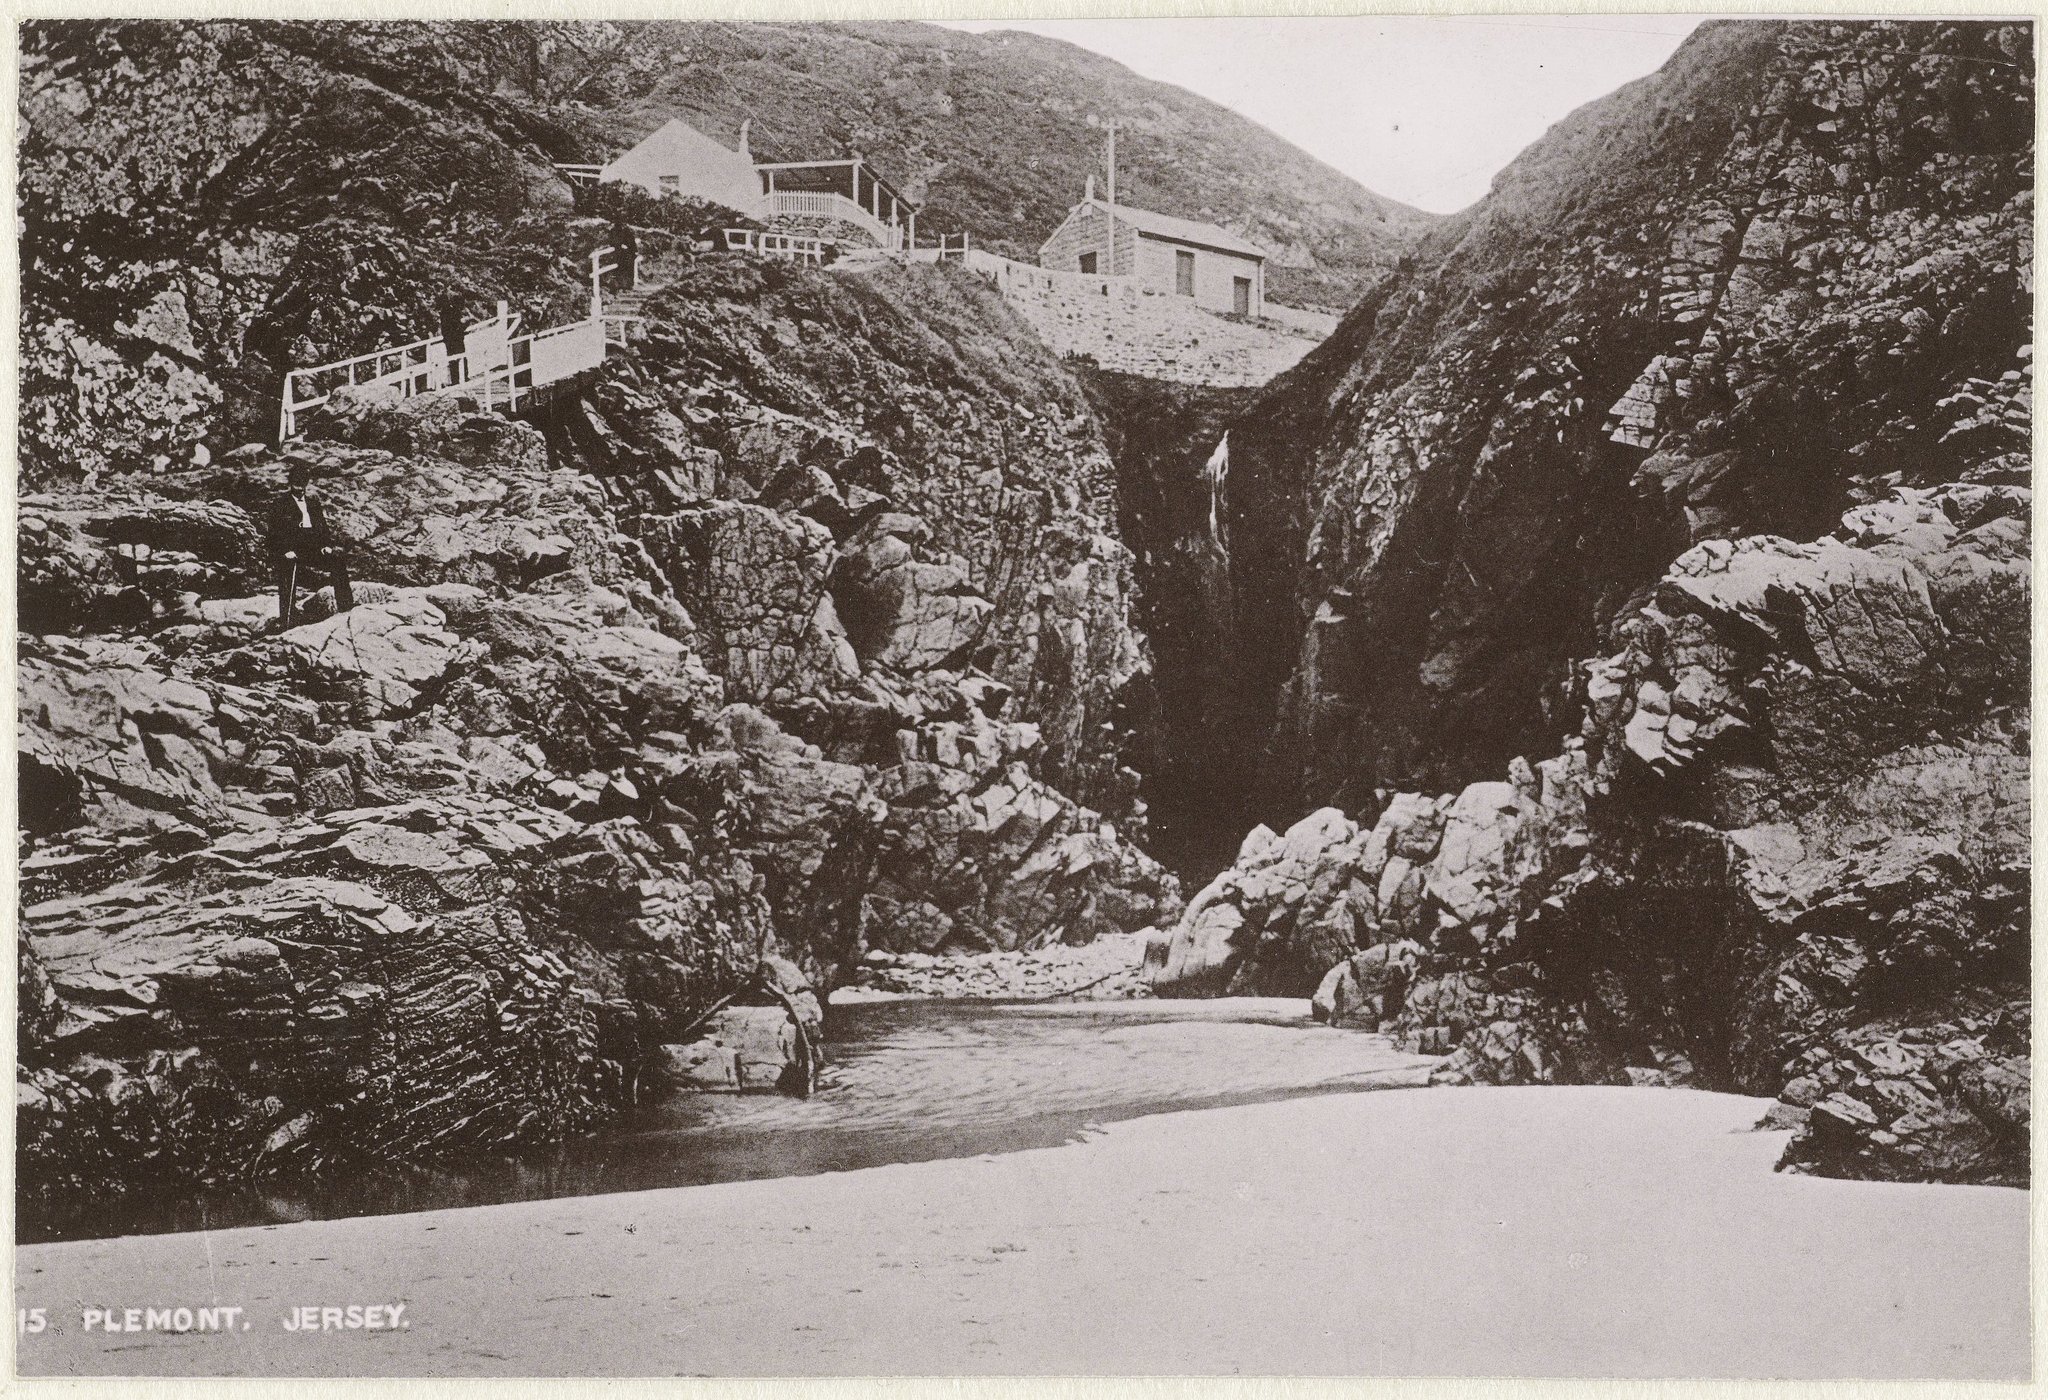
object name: photomechanical print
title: Plemont Bay op Jersey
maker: Anonymous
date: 1870-1930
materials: paper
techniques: photograph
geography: jersey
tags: gulf, bay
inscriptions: number: ‘15’